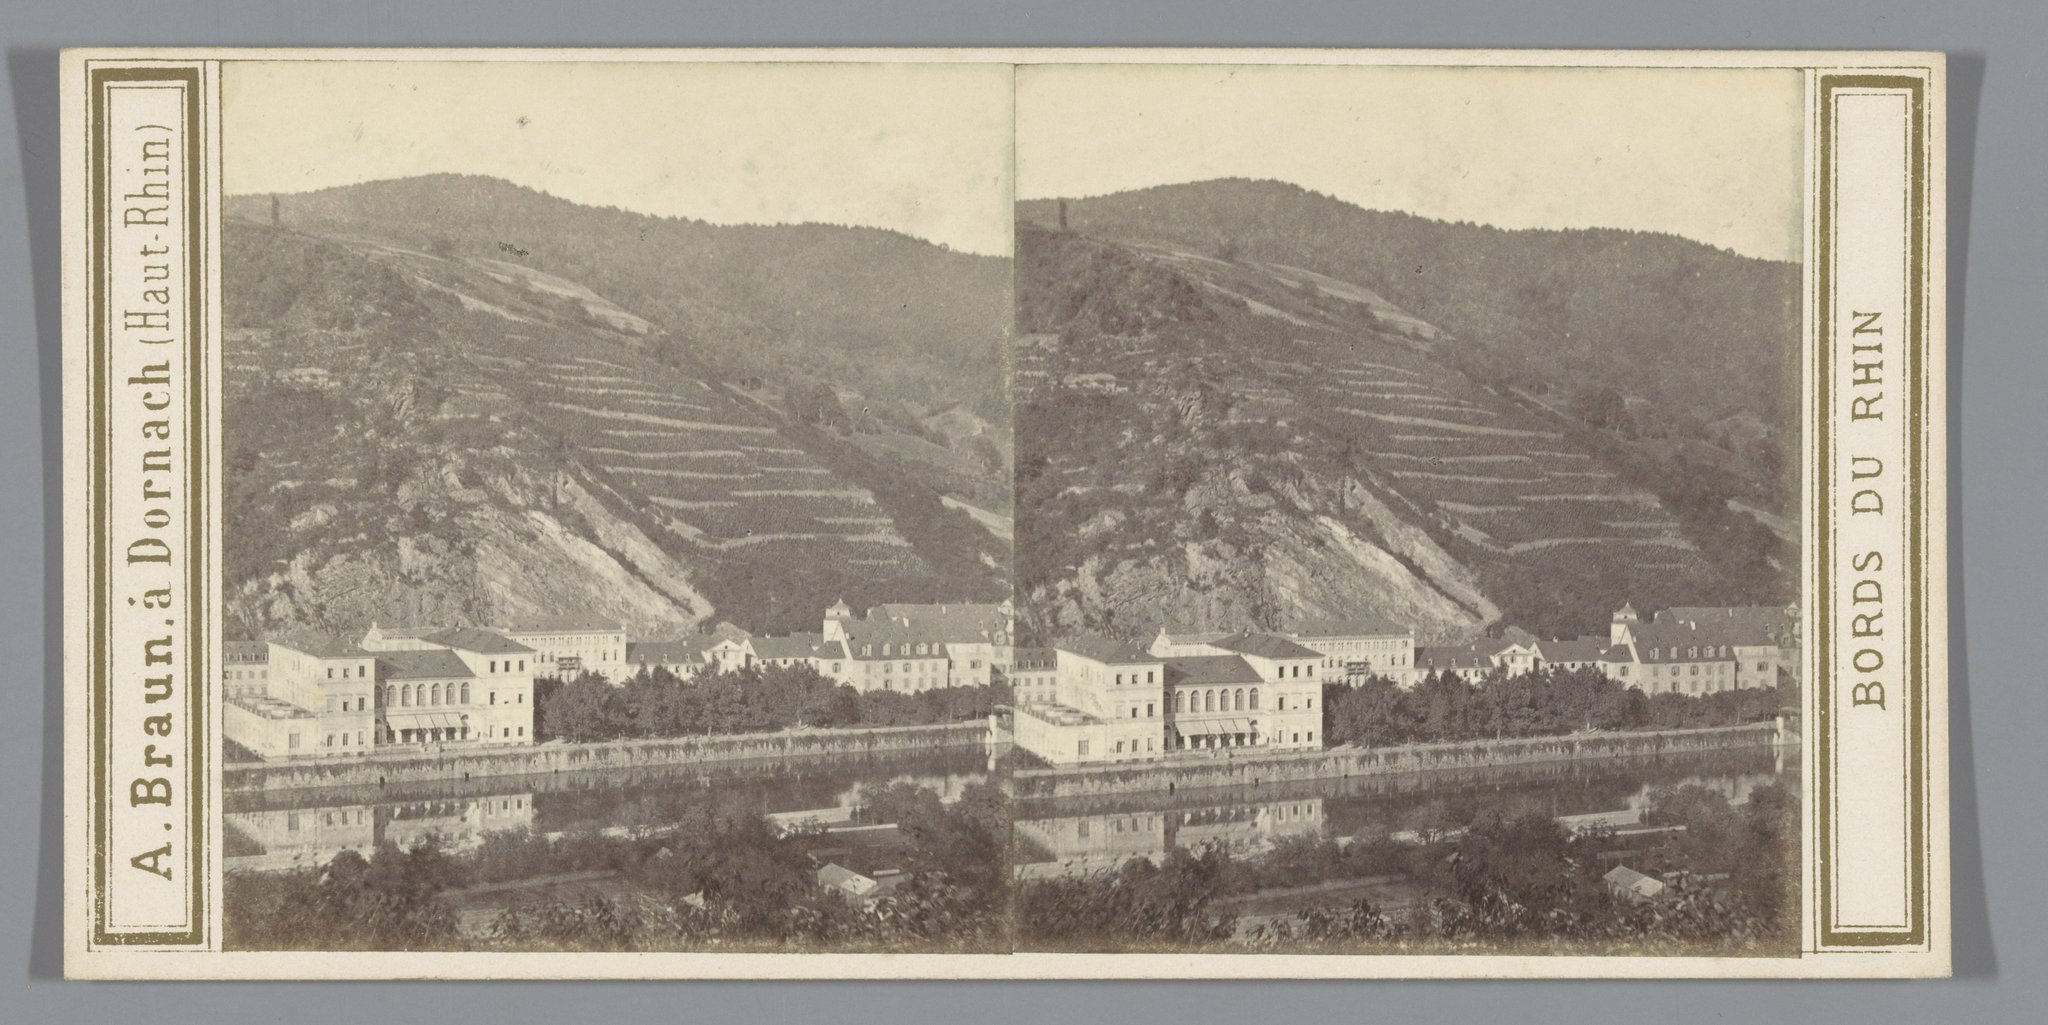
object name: stereograph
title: Panorama depuis le chalet suisse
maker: Anonymous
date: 1860-1866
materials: cardboard, paper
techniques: albumen print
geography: dornach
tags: city-view in general; 'veduta', river, watering-place, spa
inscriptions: number: ‘No 4905.’